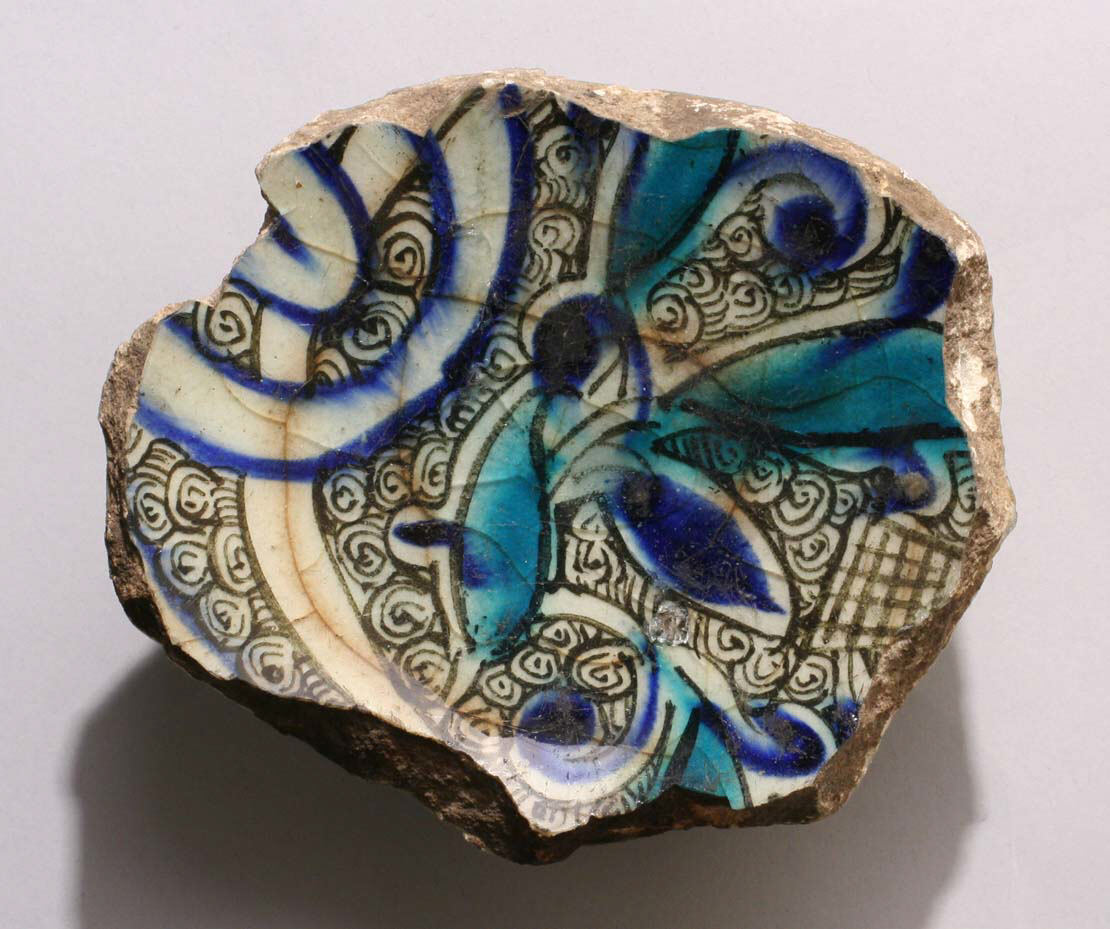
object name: fragment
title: Ceramic Fragment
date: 1301-1400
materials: stonepaste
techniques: painting, polychrome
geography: syria